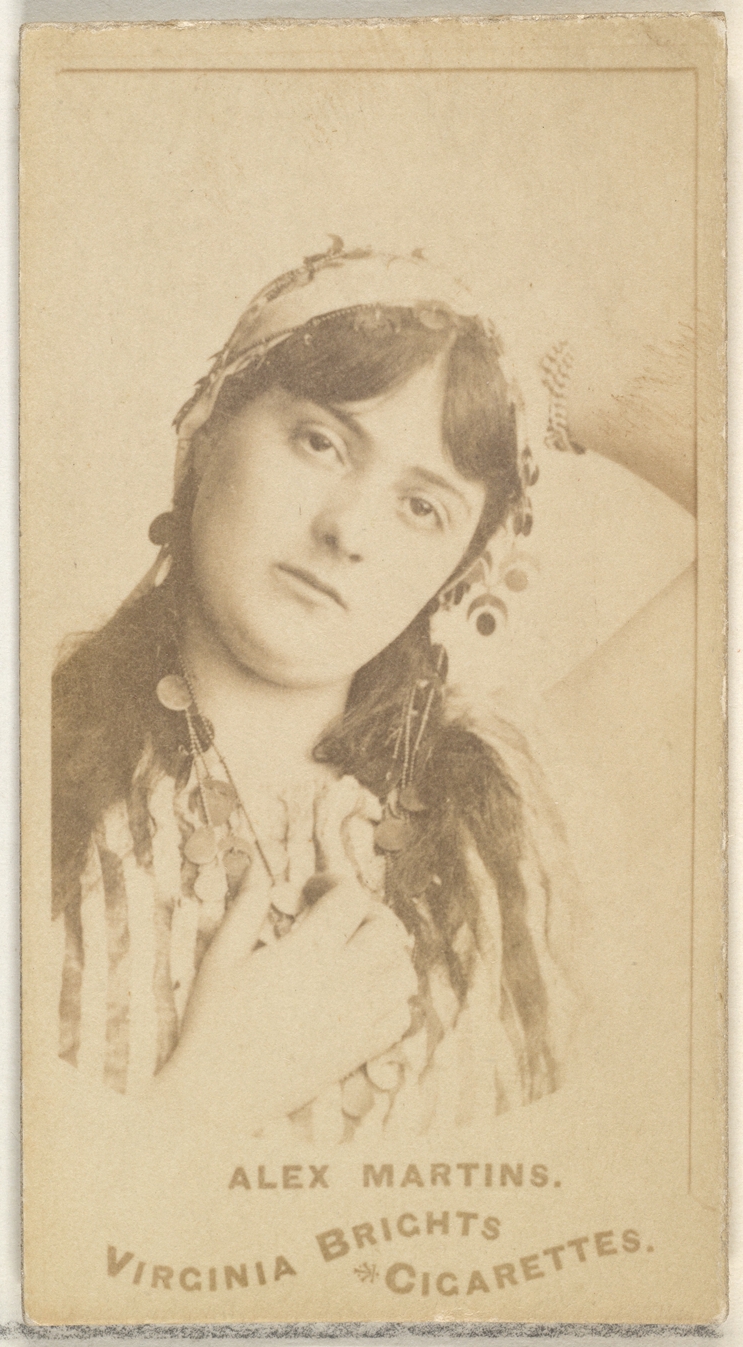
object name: photograph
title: Alex Martins, from the Actors and Actresses series (N45, Type 1) for Virginia Brights Cigarettes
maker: allen & ginter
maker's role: publisher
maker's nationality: american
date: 1888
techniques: albumen silver print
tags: portraits,women,actresses